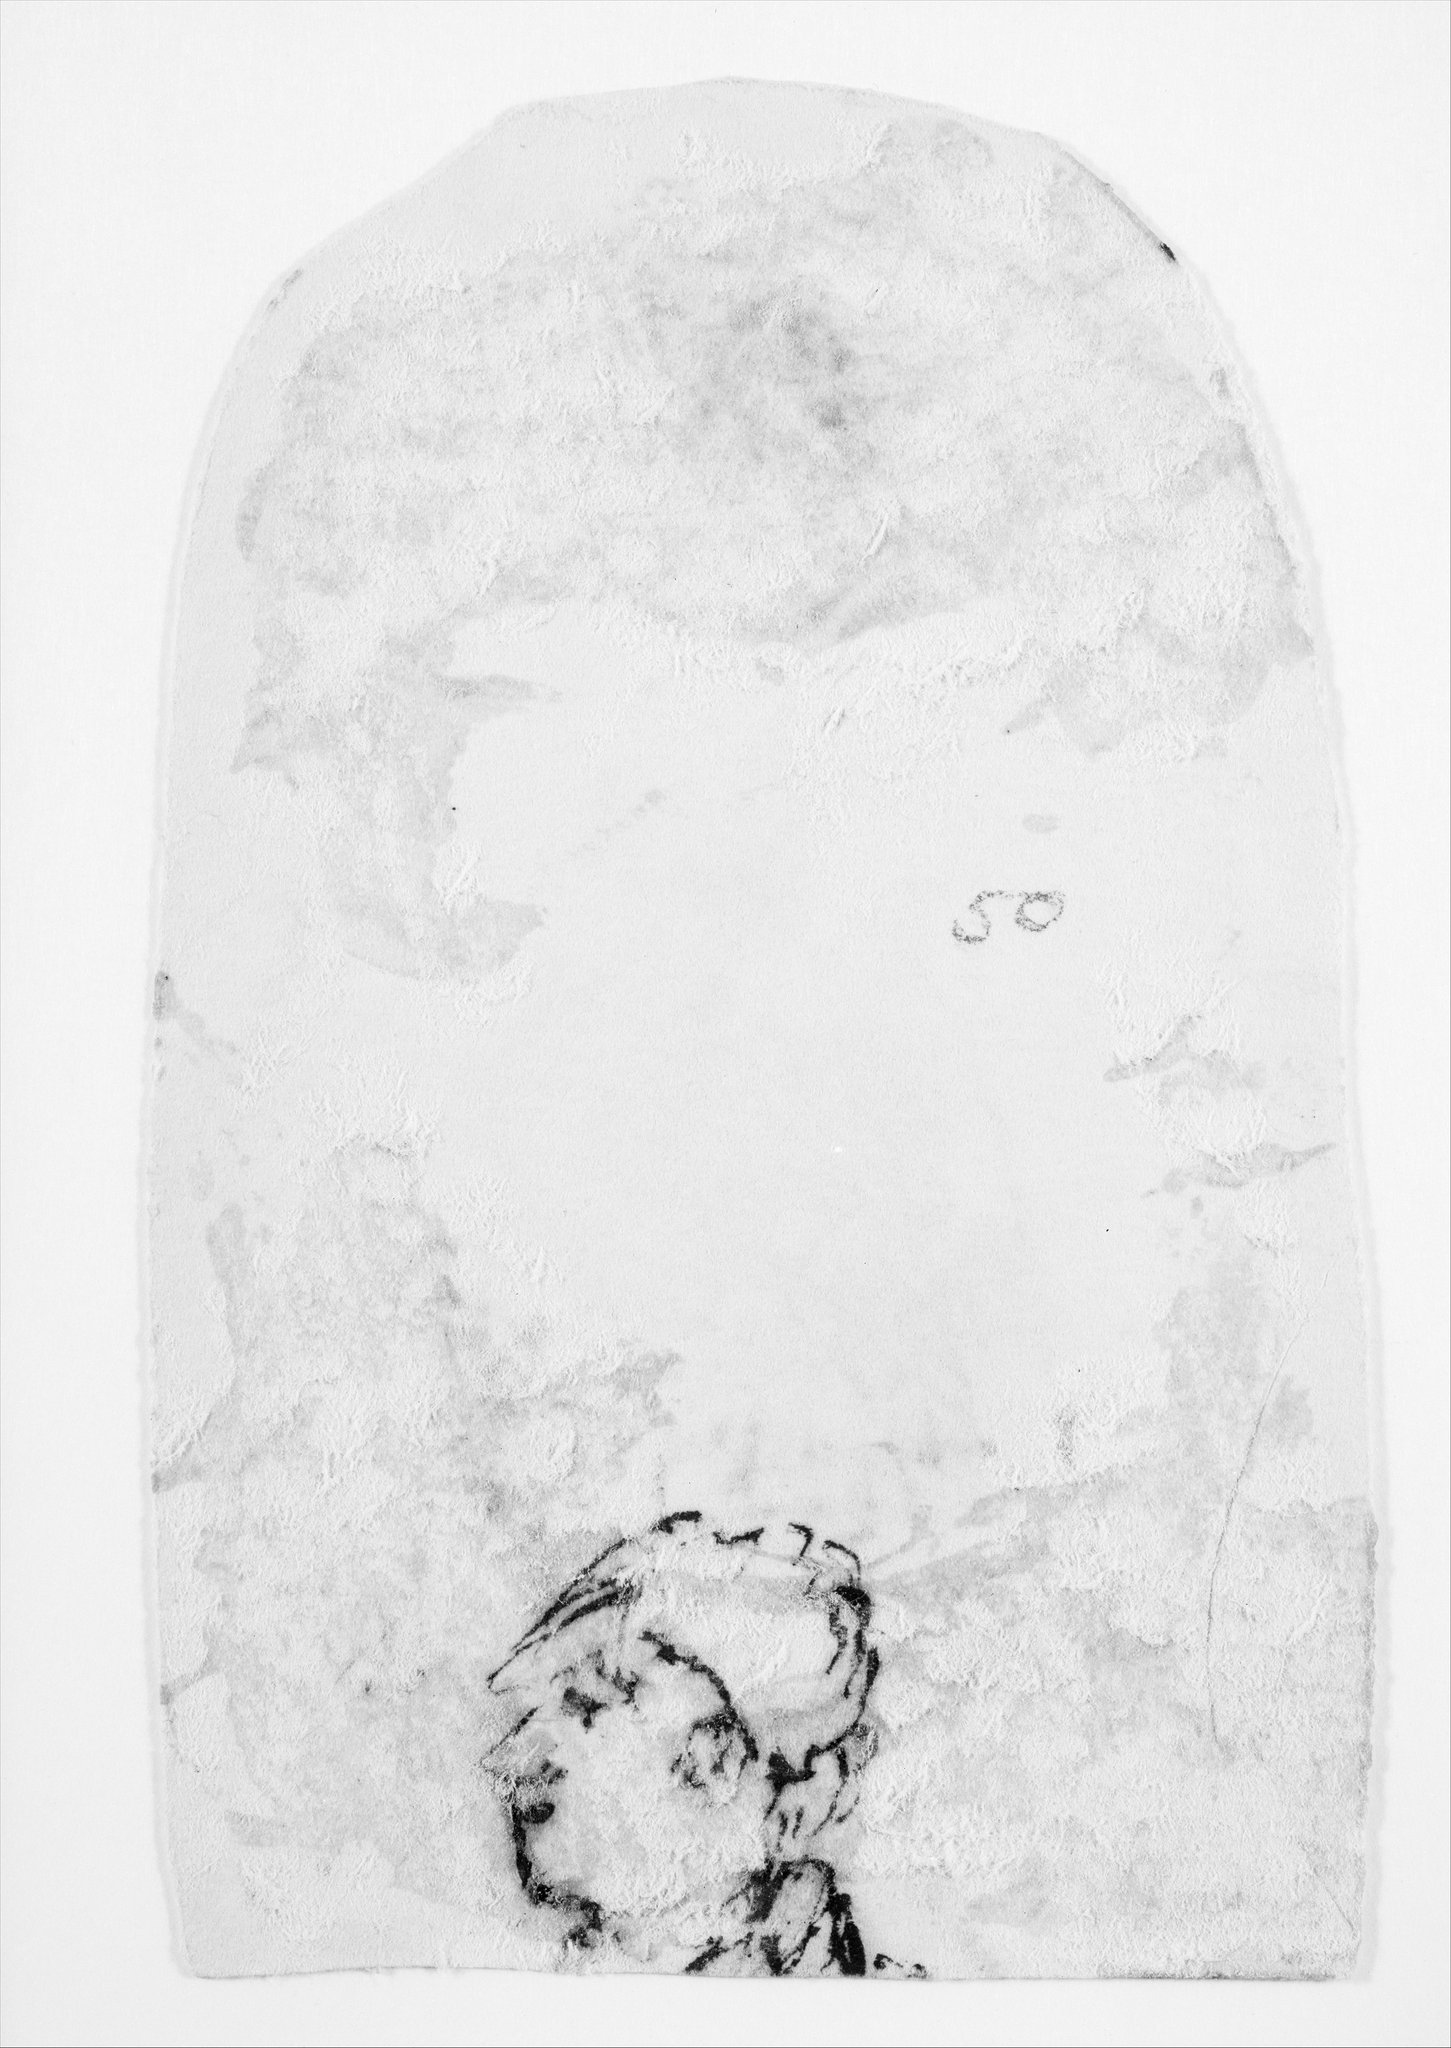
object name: drawing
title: (from Sketchbook)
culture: american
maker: james mcneill whistler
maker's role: artist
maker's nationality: american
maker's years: 1834-1903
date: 1854-1855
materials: chalk, gouache, graphite, ink, paper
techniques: drawing, pen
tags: human figures,profiles